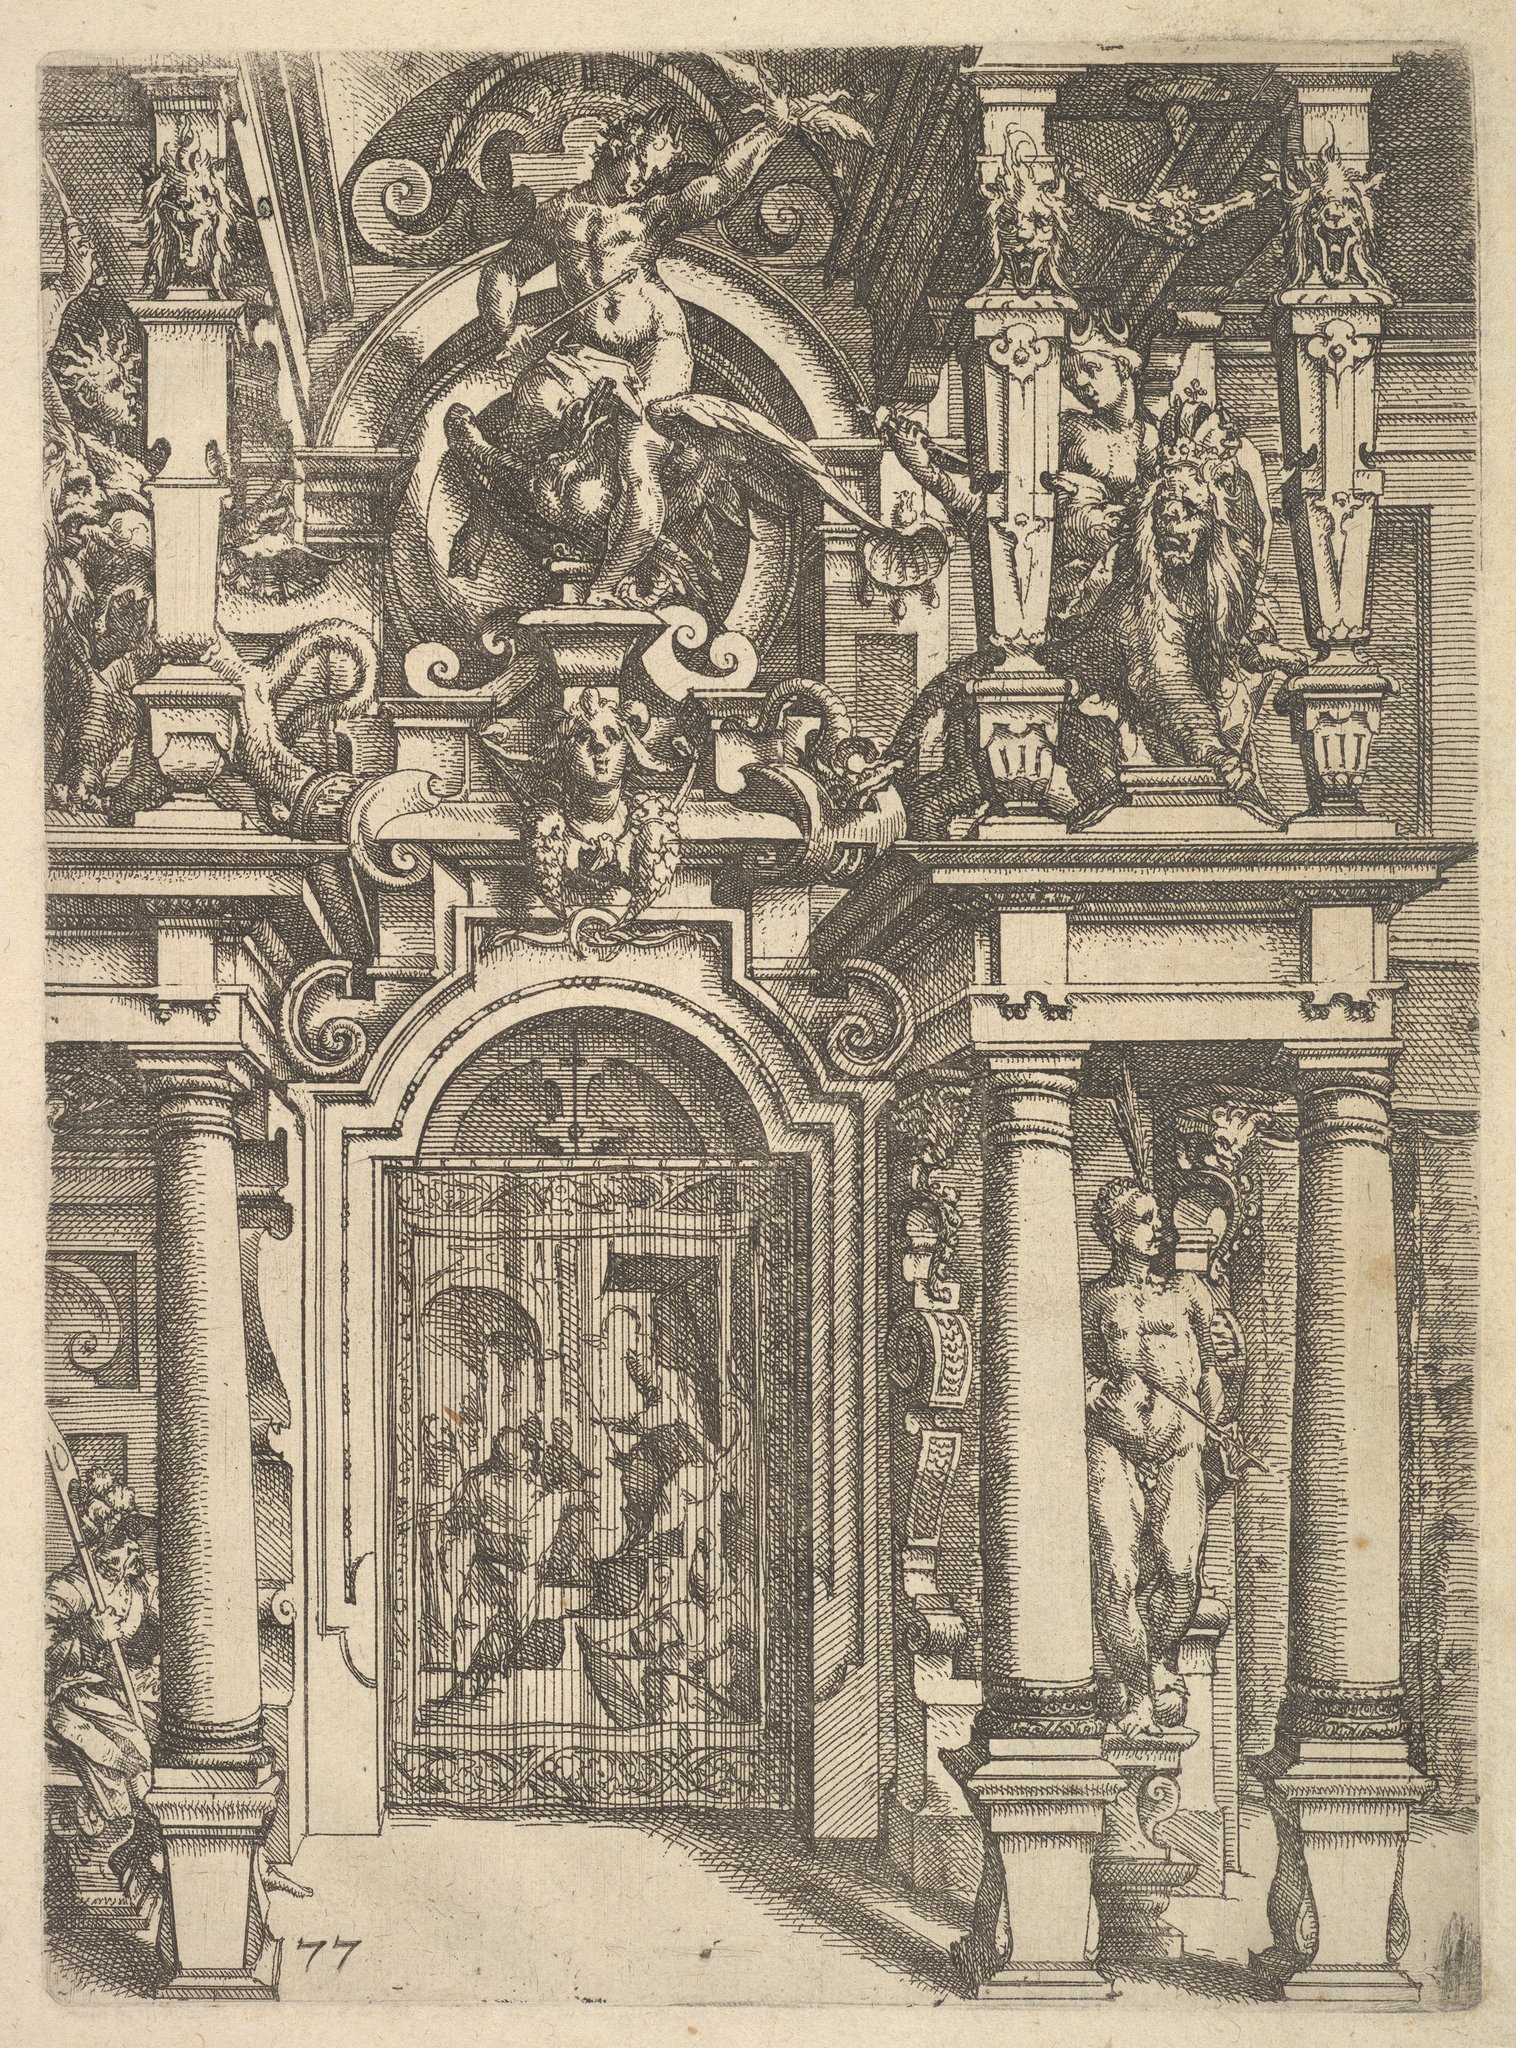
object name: print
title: Ornament plate, from "Architettura"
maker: wendel dietterlin, the elder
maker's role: artist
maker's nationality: german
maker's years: 1550-1559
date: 1598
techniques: etching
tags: birds,ornament,male nudes,lions